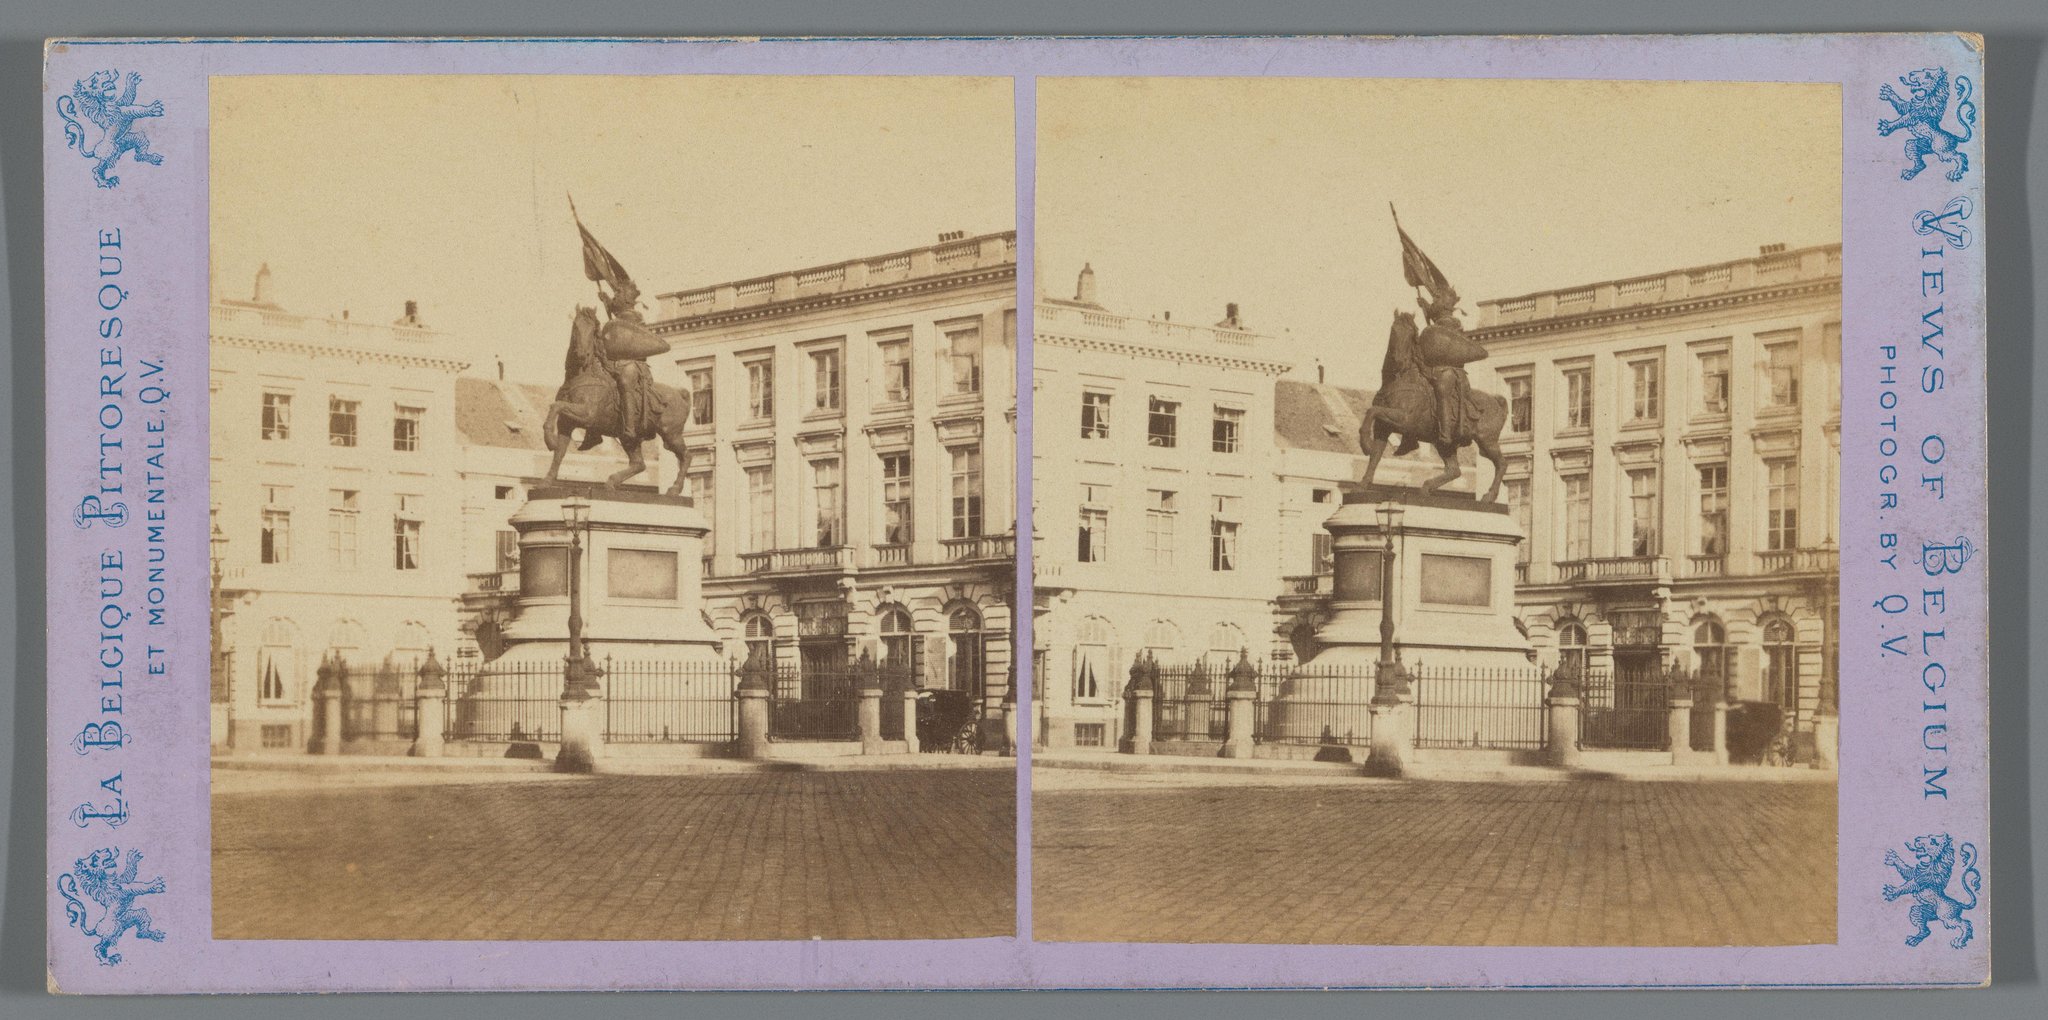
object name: stereograph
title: Bruxelles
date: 1866-1870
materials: cardboard, paper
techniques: albumen print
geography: brussels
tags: equestrian statue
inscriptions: number: ‘No 1619’